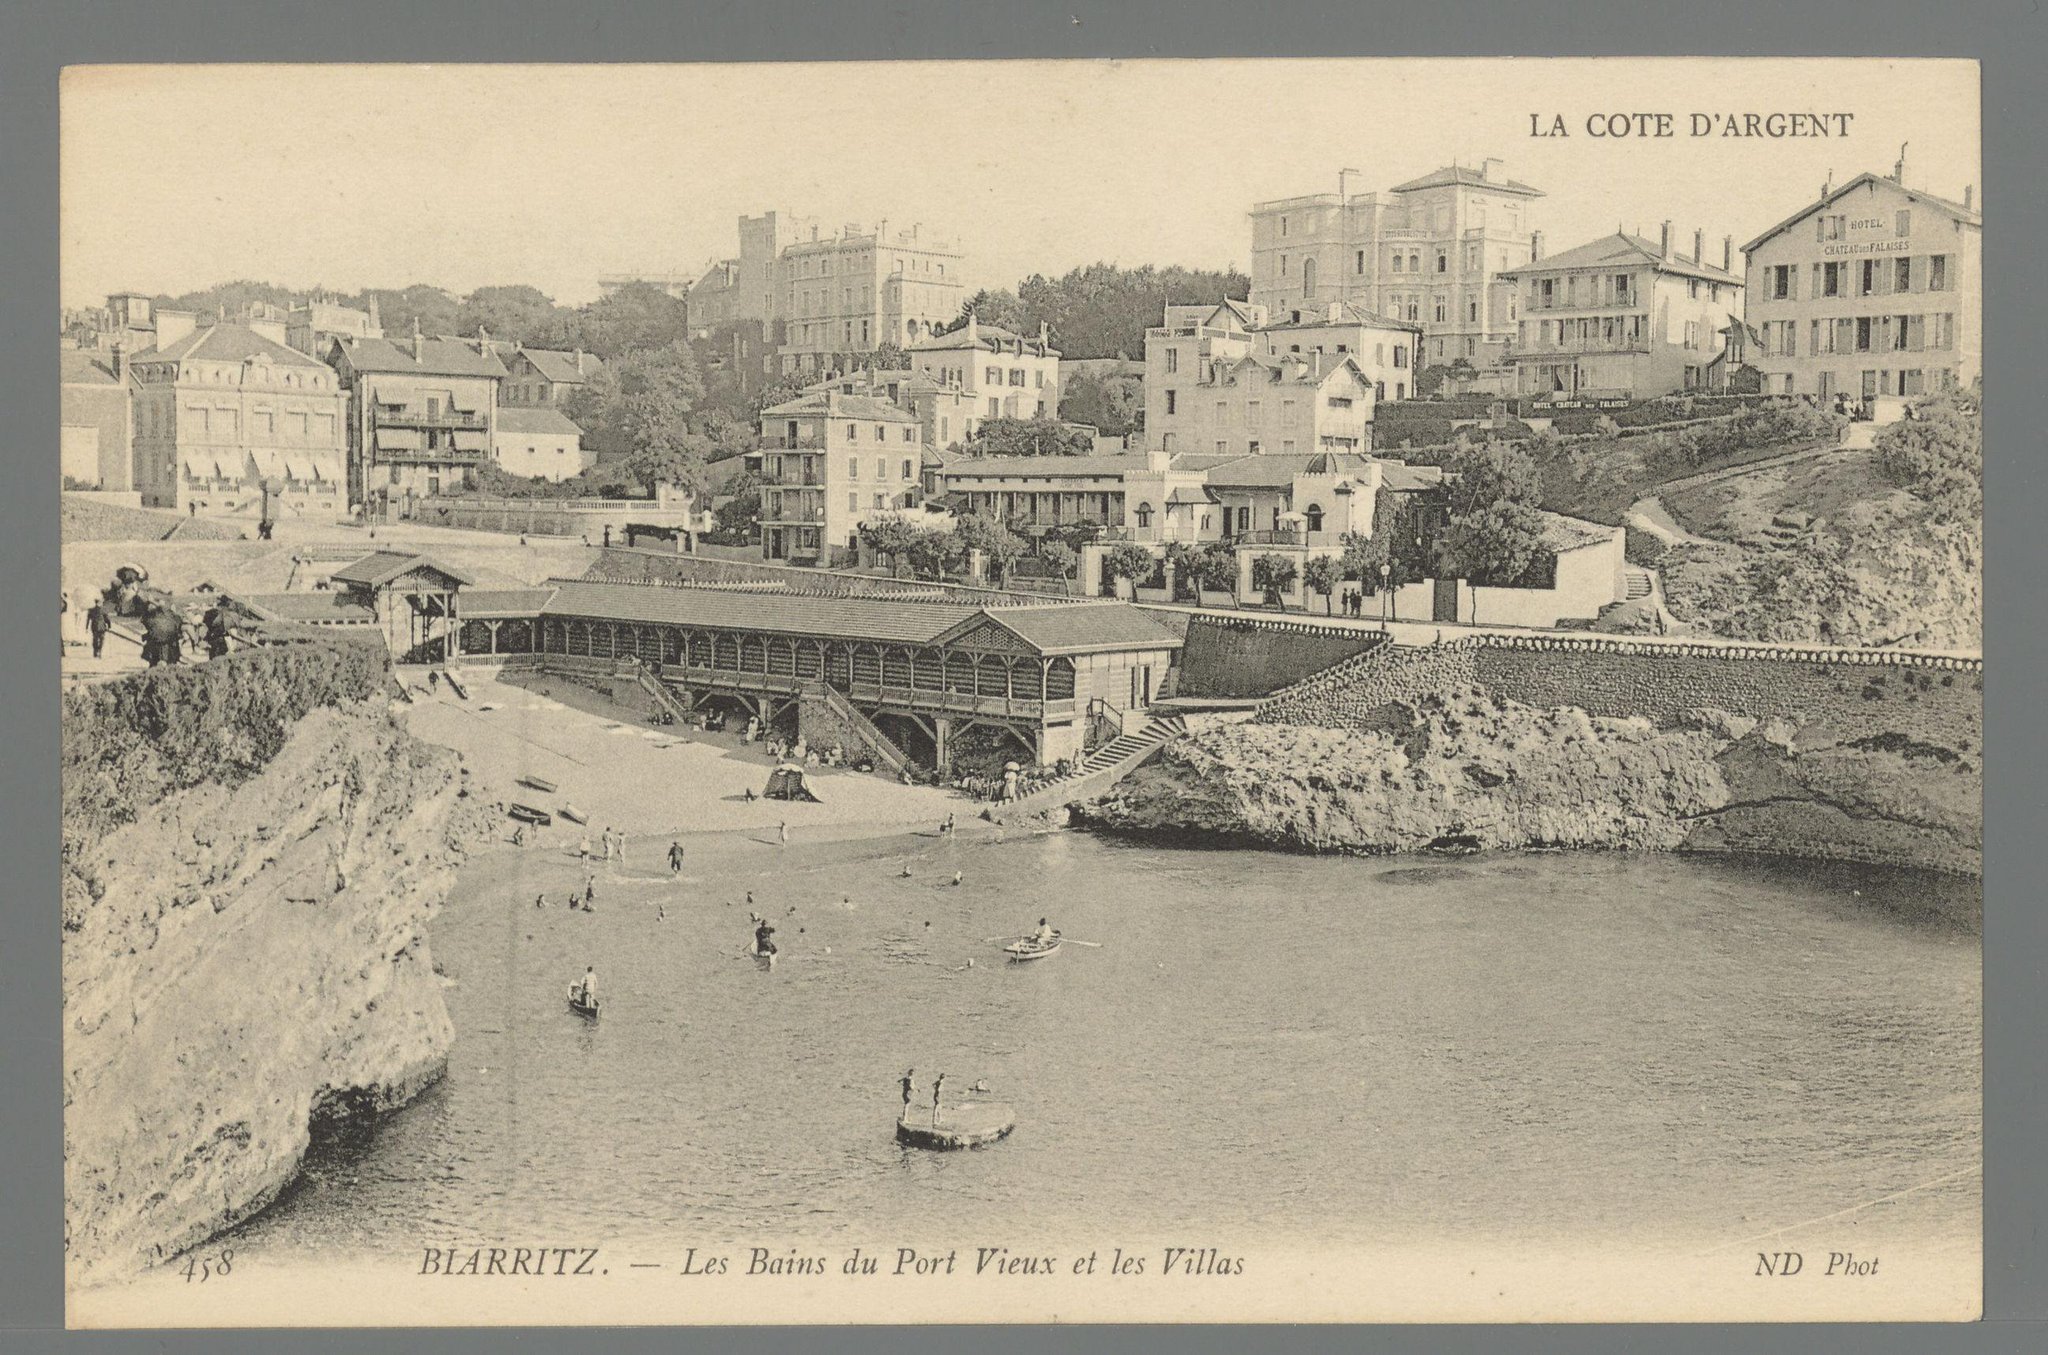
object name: photomechanical print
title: La cote d'argent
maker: Anonymous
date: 1903-1918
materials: cardboard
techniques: photograph, writing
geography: biarritz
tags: urban housing, landscapes with waters, waterscapes, seascapes (in the temperate zone), in or beside the water (on the beach)